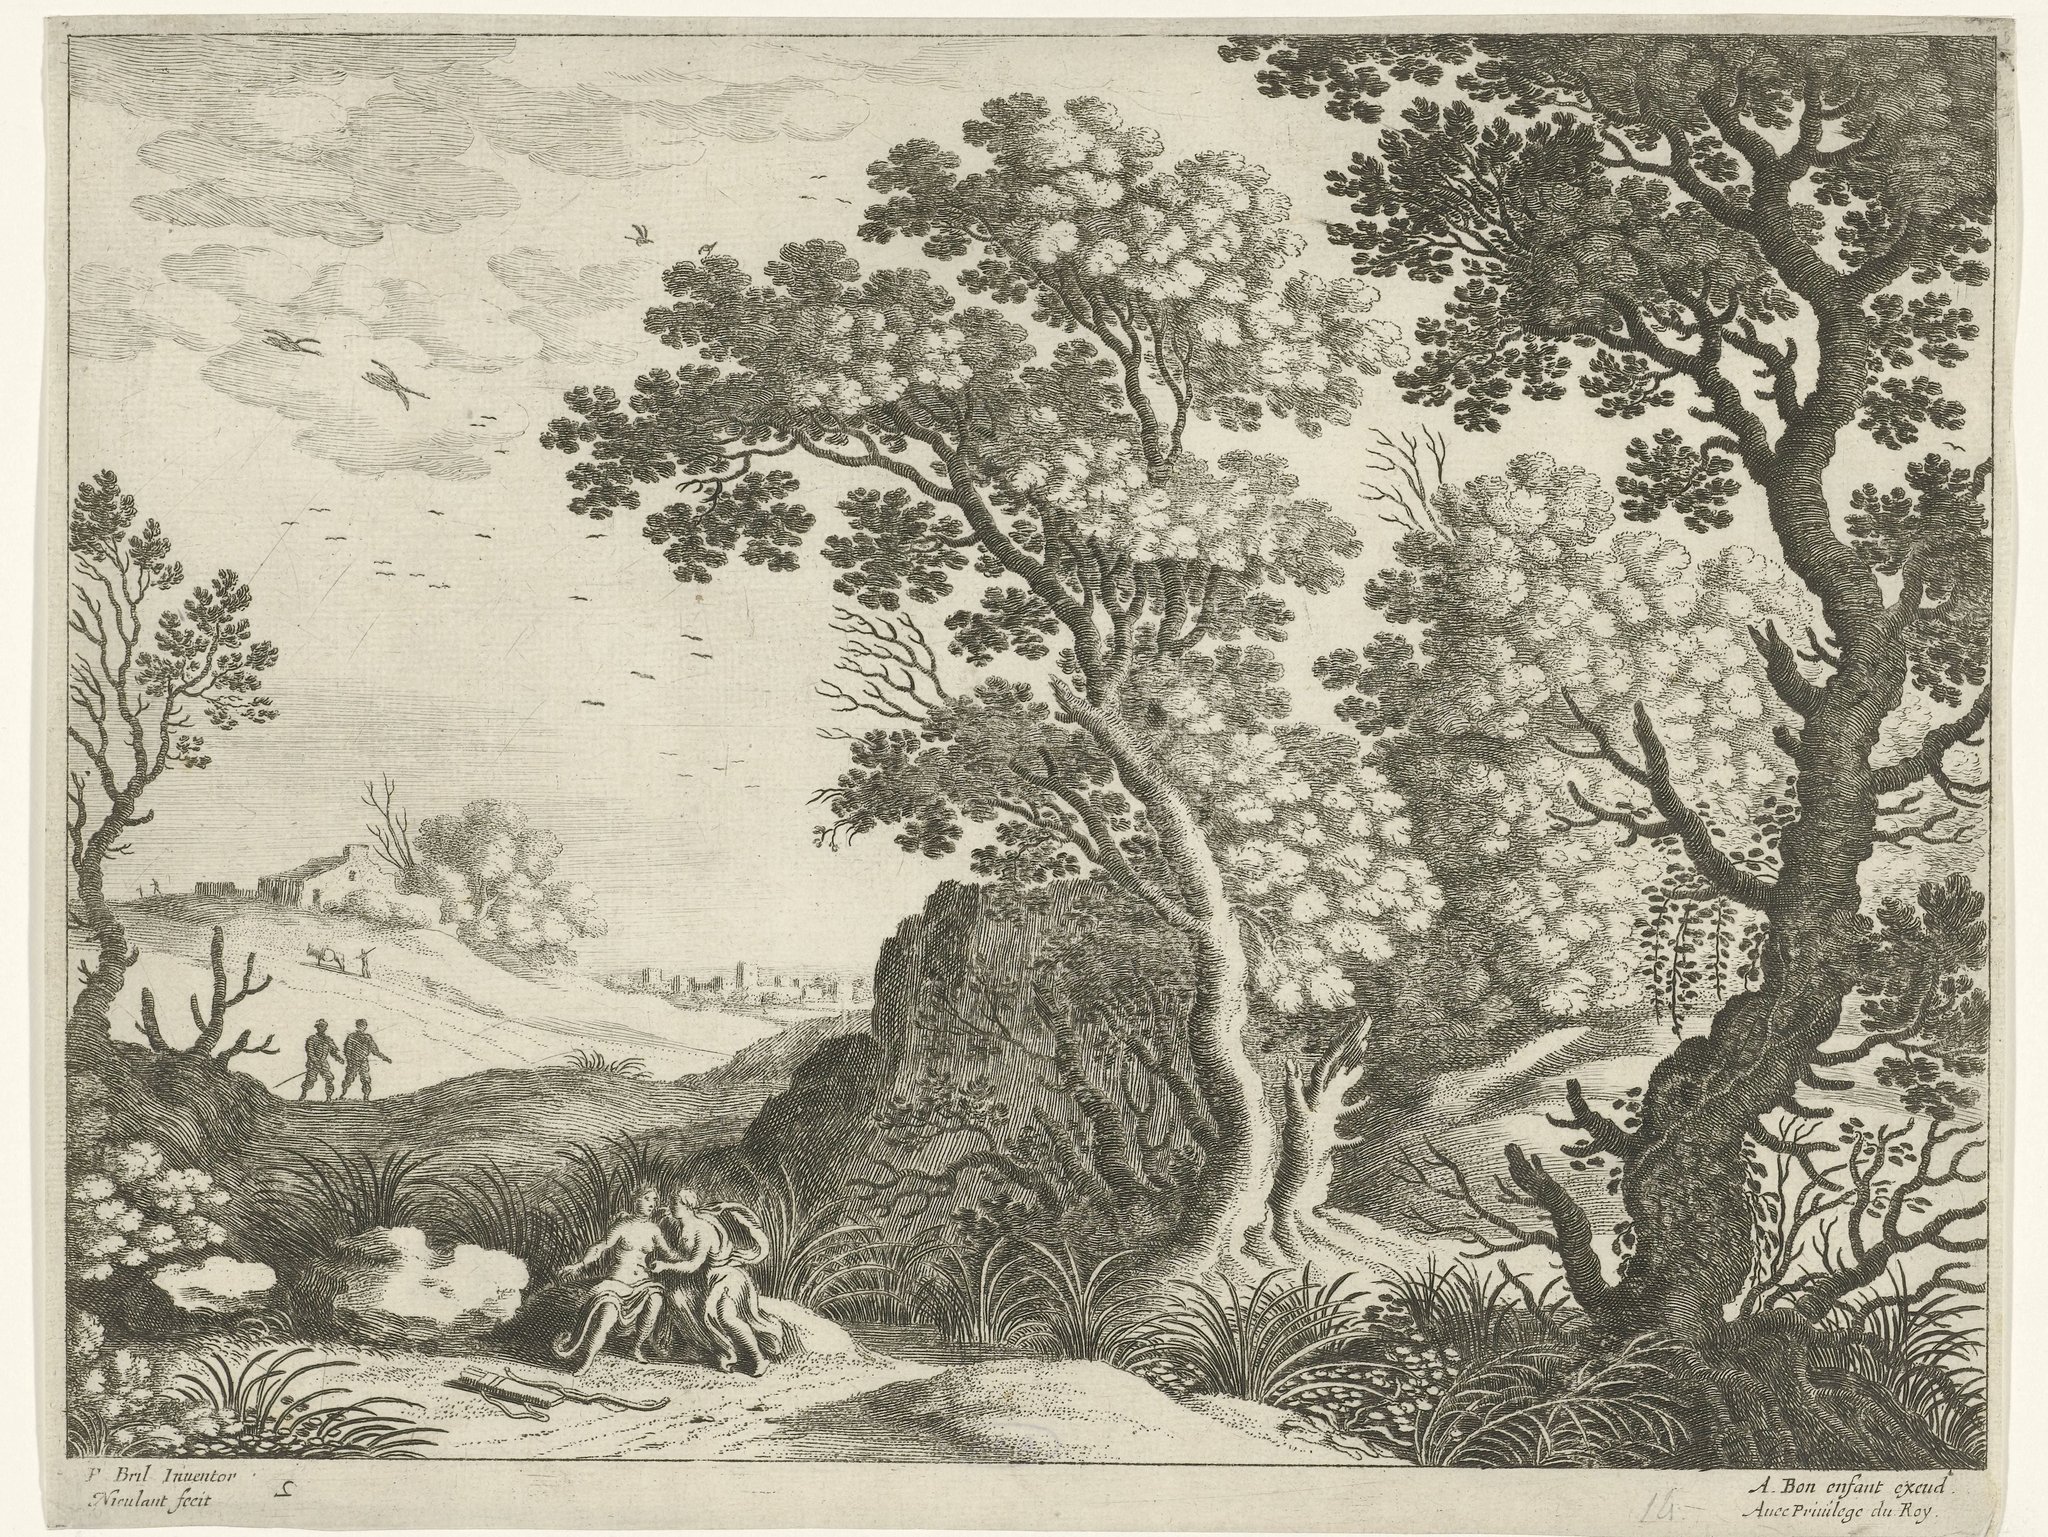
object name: print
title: Italiaanse landschappen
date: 1594-1635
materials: paper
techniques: engraving, etching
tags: companions, nymphs of diana; 'ninfe di diana' (ripa), (story of) diana (artemis), landscapes in the temperate zone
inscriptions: collector's mark: Lugt 2228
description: In een landschap zitten Diana en een nimf. Voor hen op de grond liggen een boog en een pijlenkoker. Op de achtergrond naderen twee mannen en ligt een boerderij. Prent uit een serie Italiaanse landschappen.